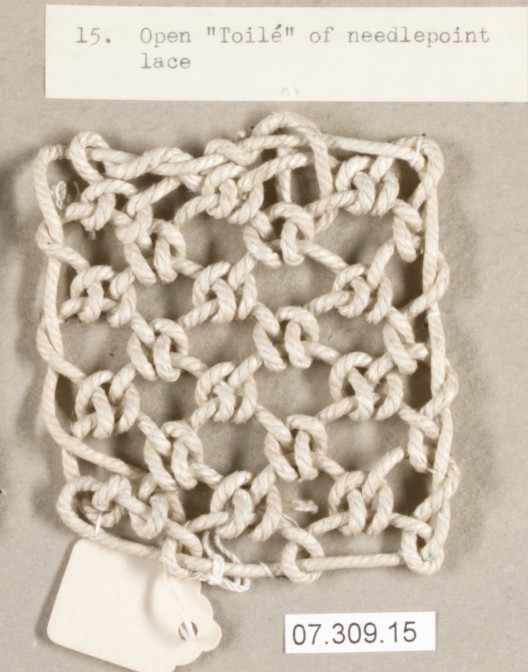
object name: stitch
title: Example of lace stitch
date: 1801-2000